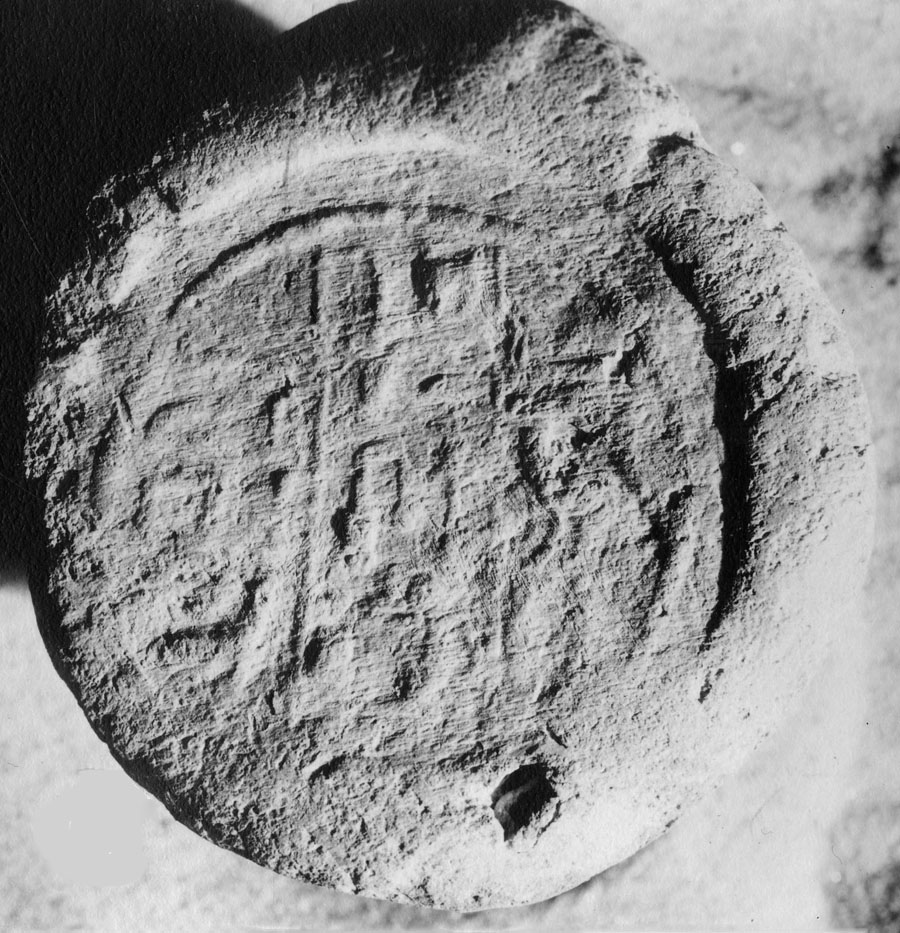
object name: cone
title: Funerary Cone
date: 1550-1295 BCE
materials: pottery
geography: egypt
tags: hieroglyphs